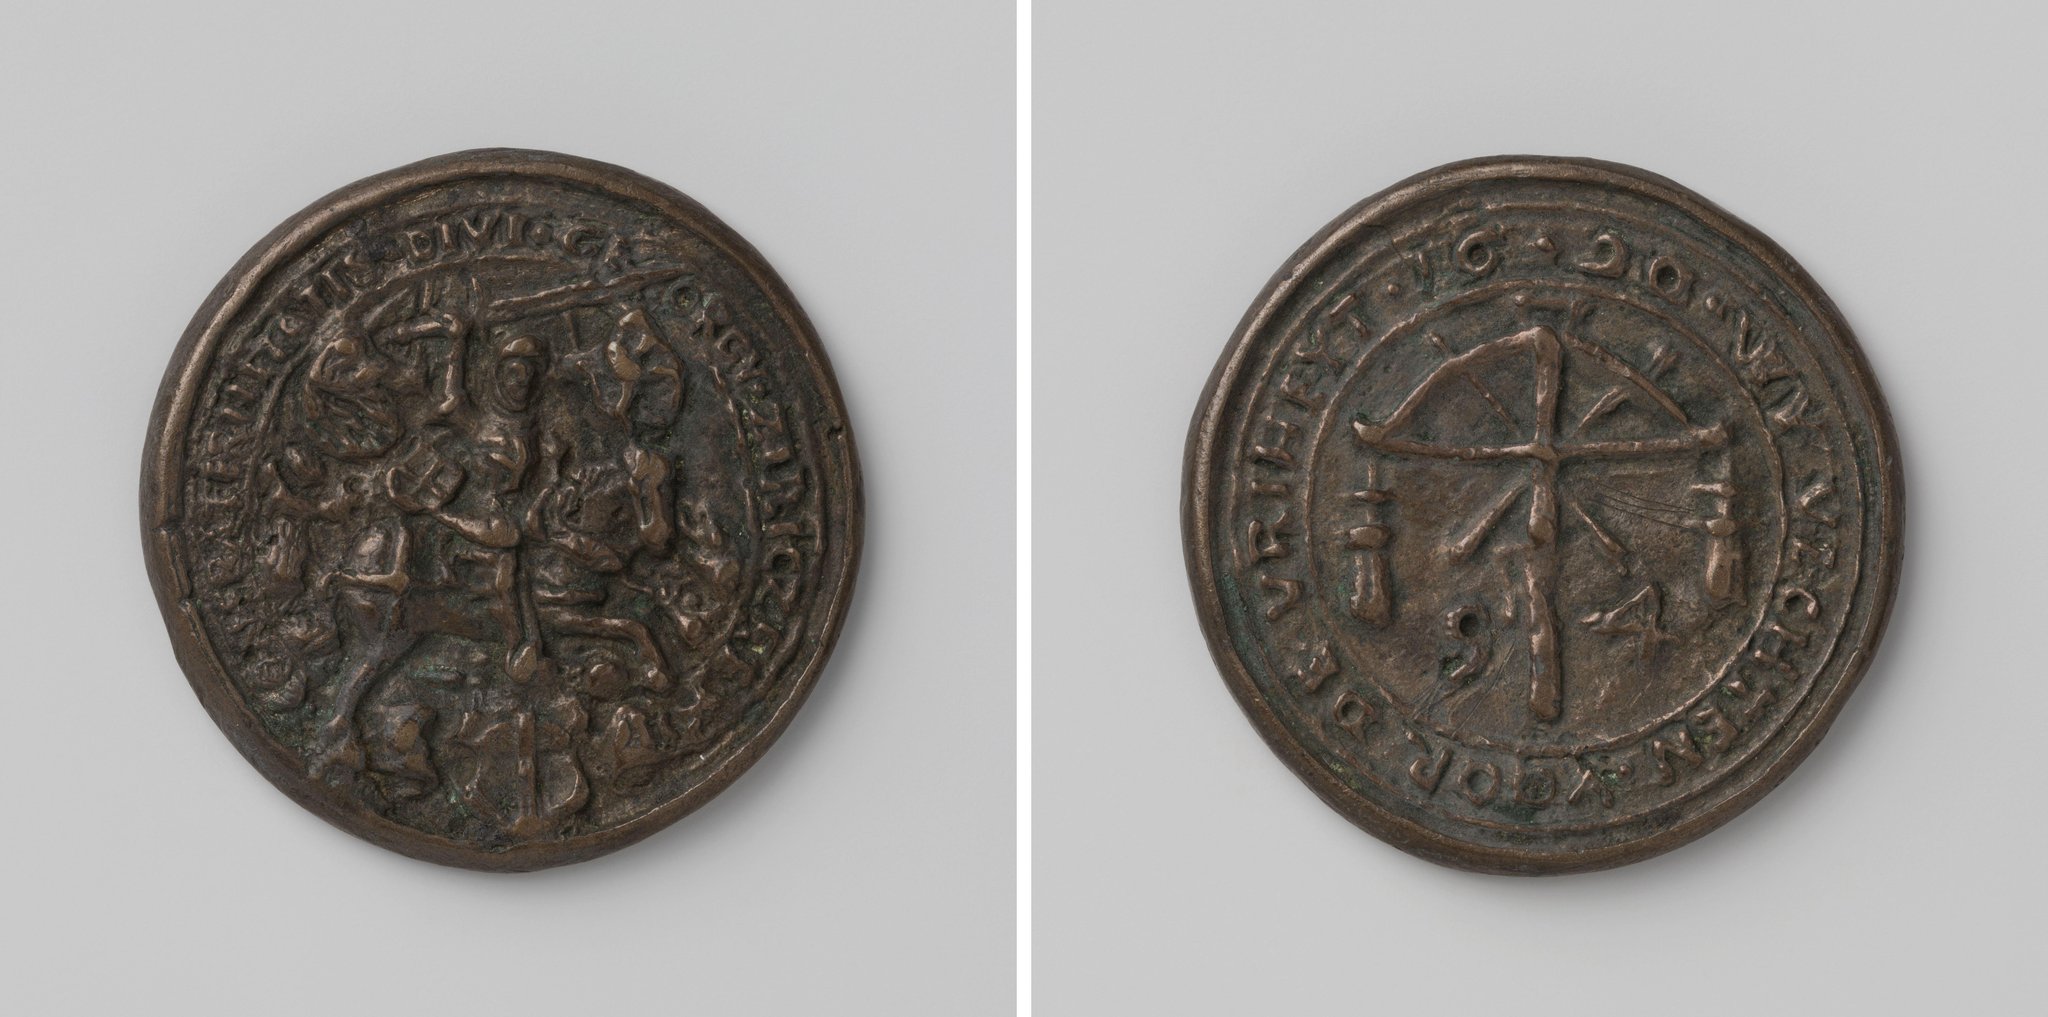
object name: marksman medal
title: Confrerie van St. Joris te Zierikzee, schutterspenning met no. 54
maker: Anonymous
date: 1620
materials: copper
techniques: casting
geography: middelburg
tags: zierikzee